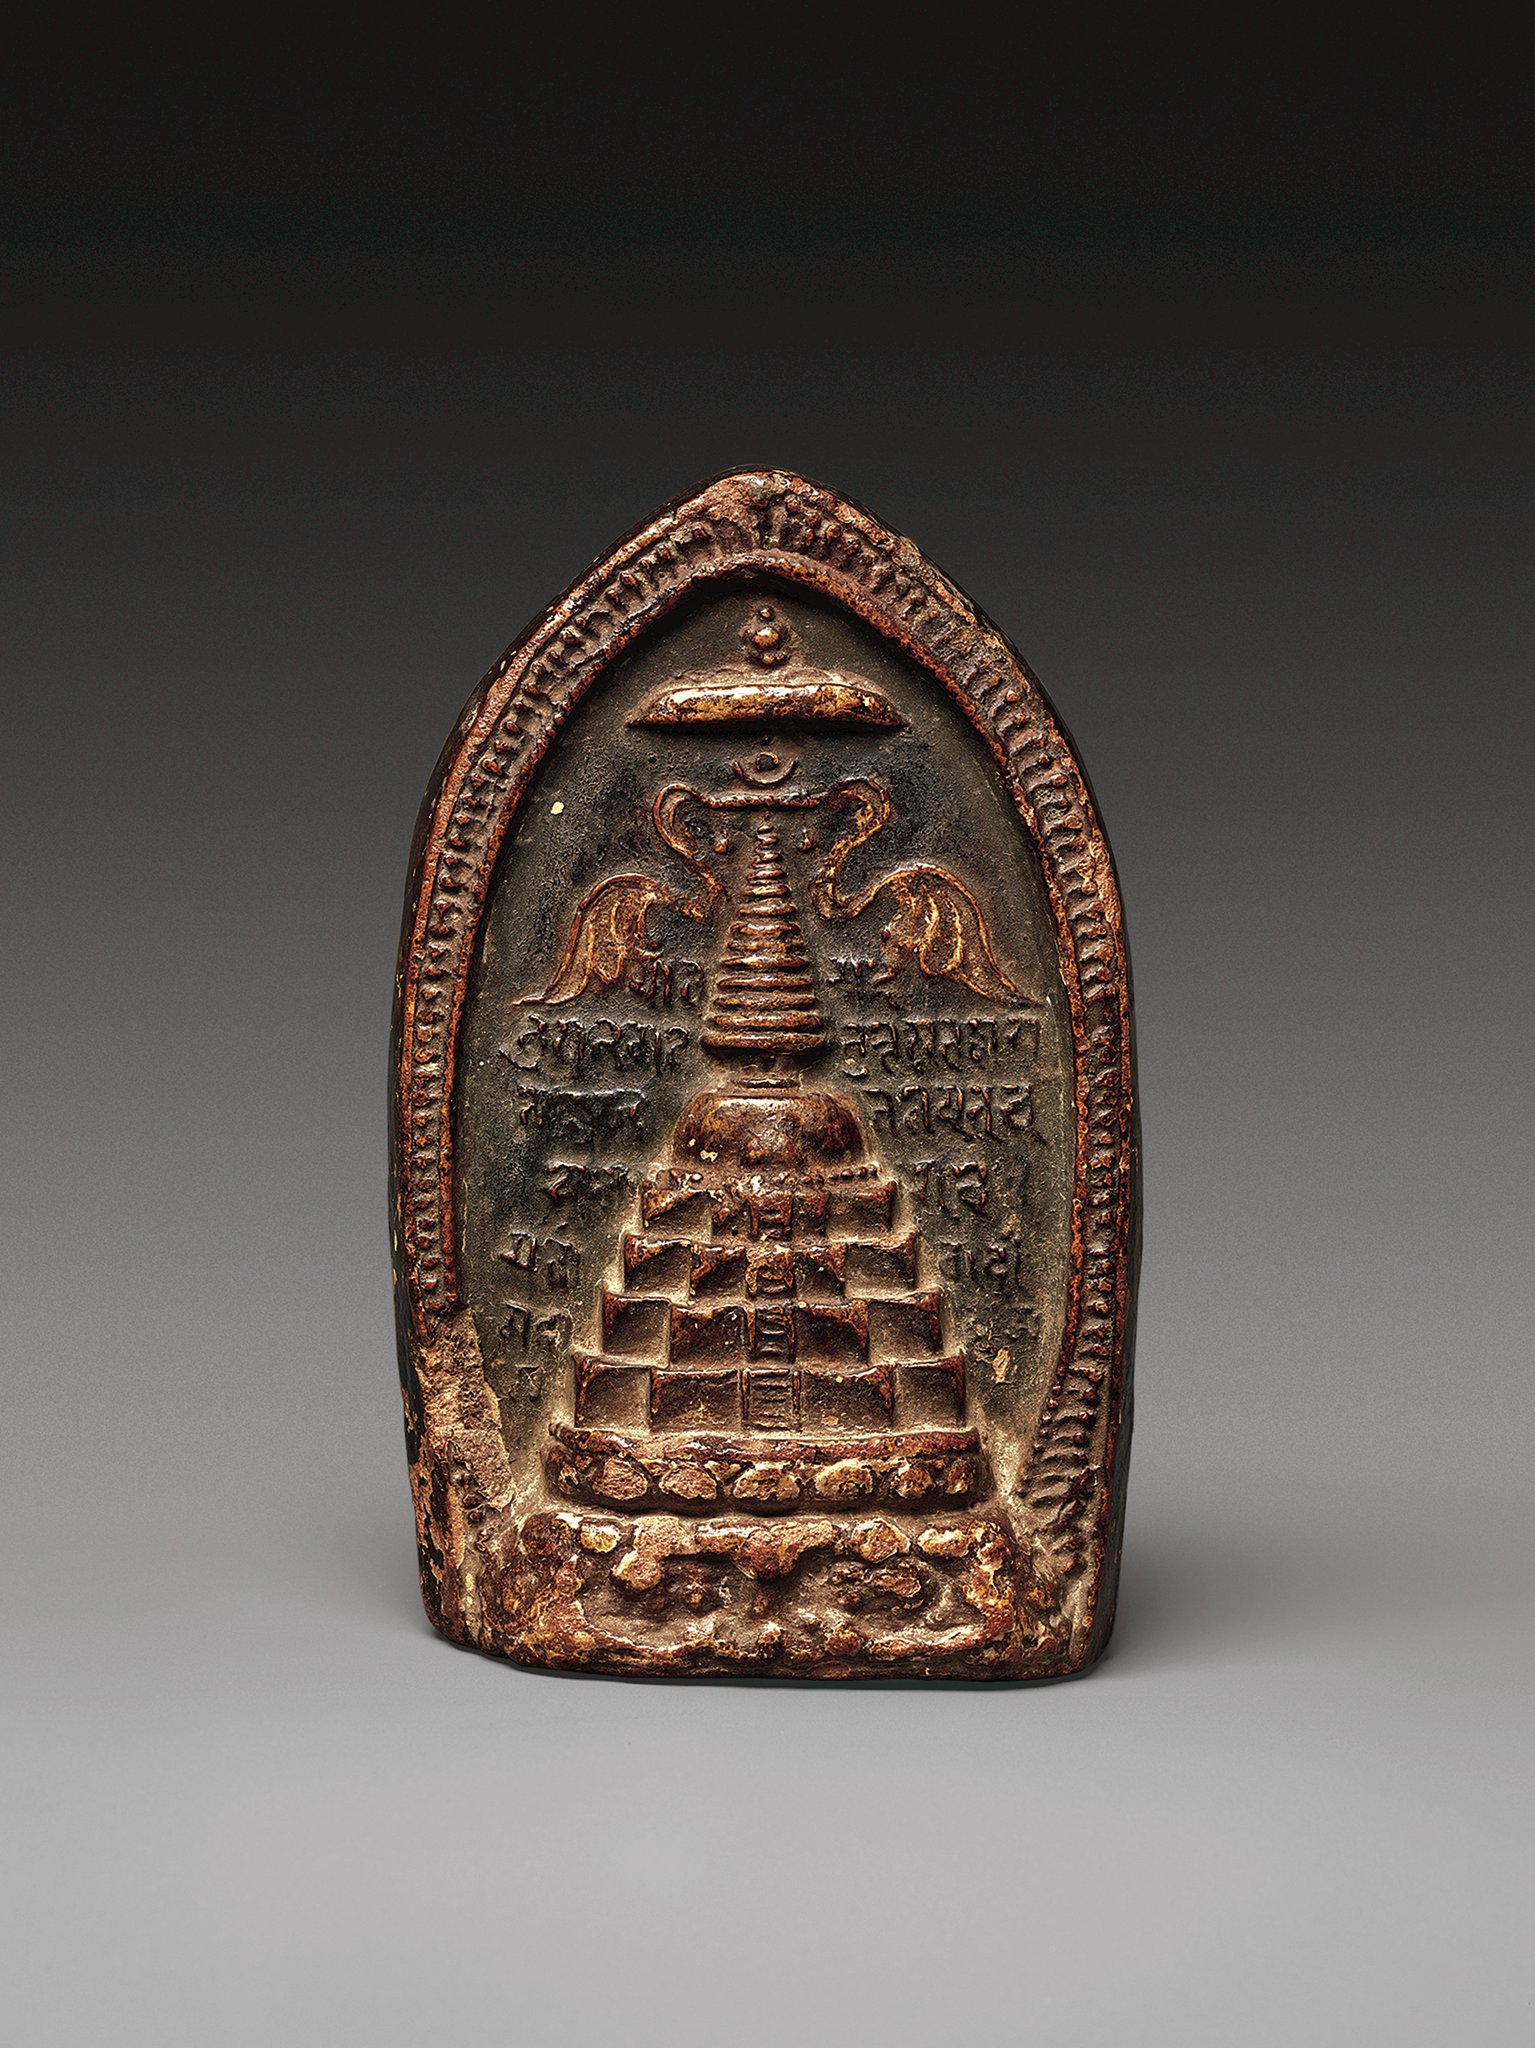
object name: votive plaque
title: Votive Plaque (Tsa Tsa) Depicting a Stupa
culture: tibetan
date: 901-1100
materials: clay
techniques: painting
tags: stupas